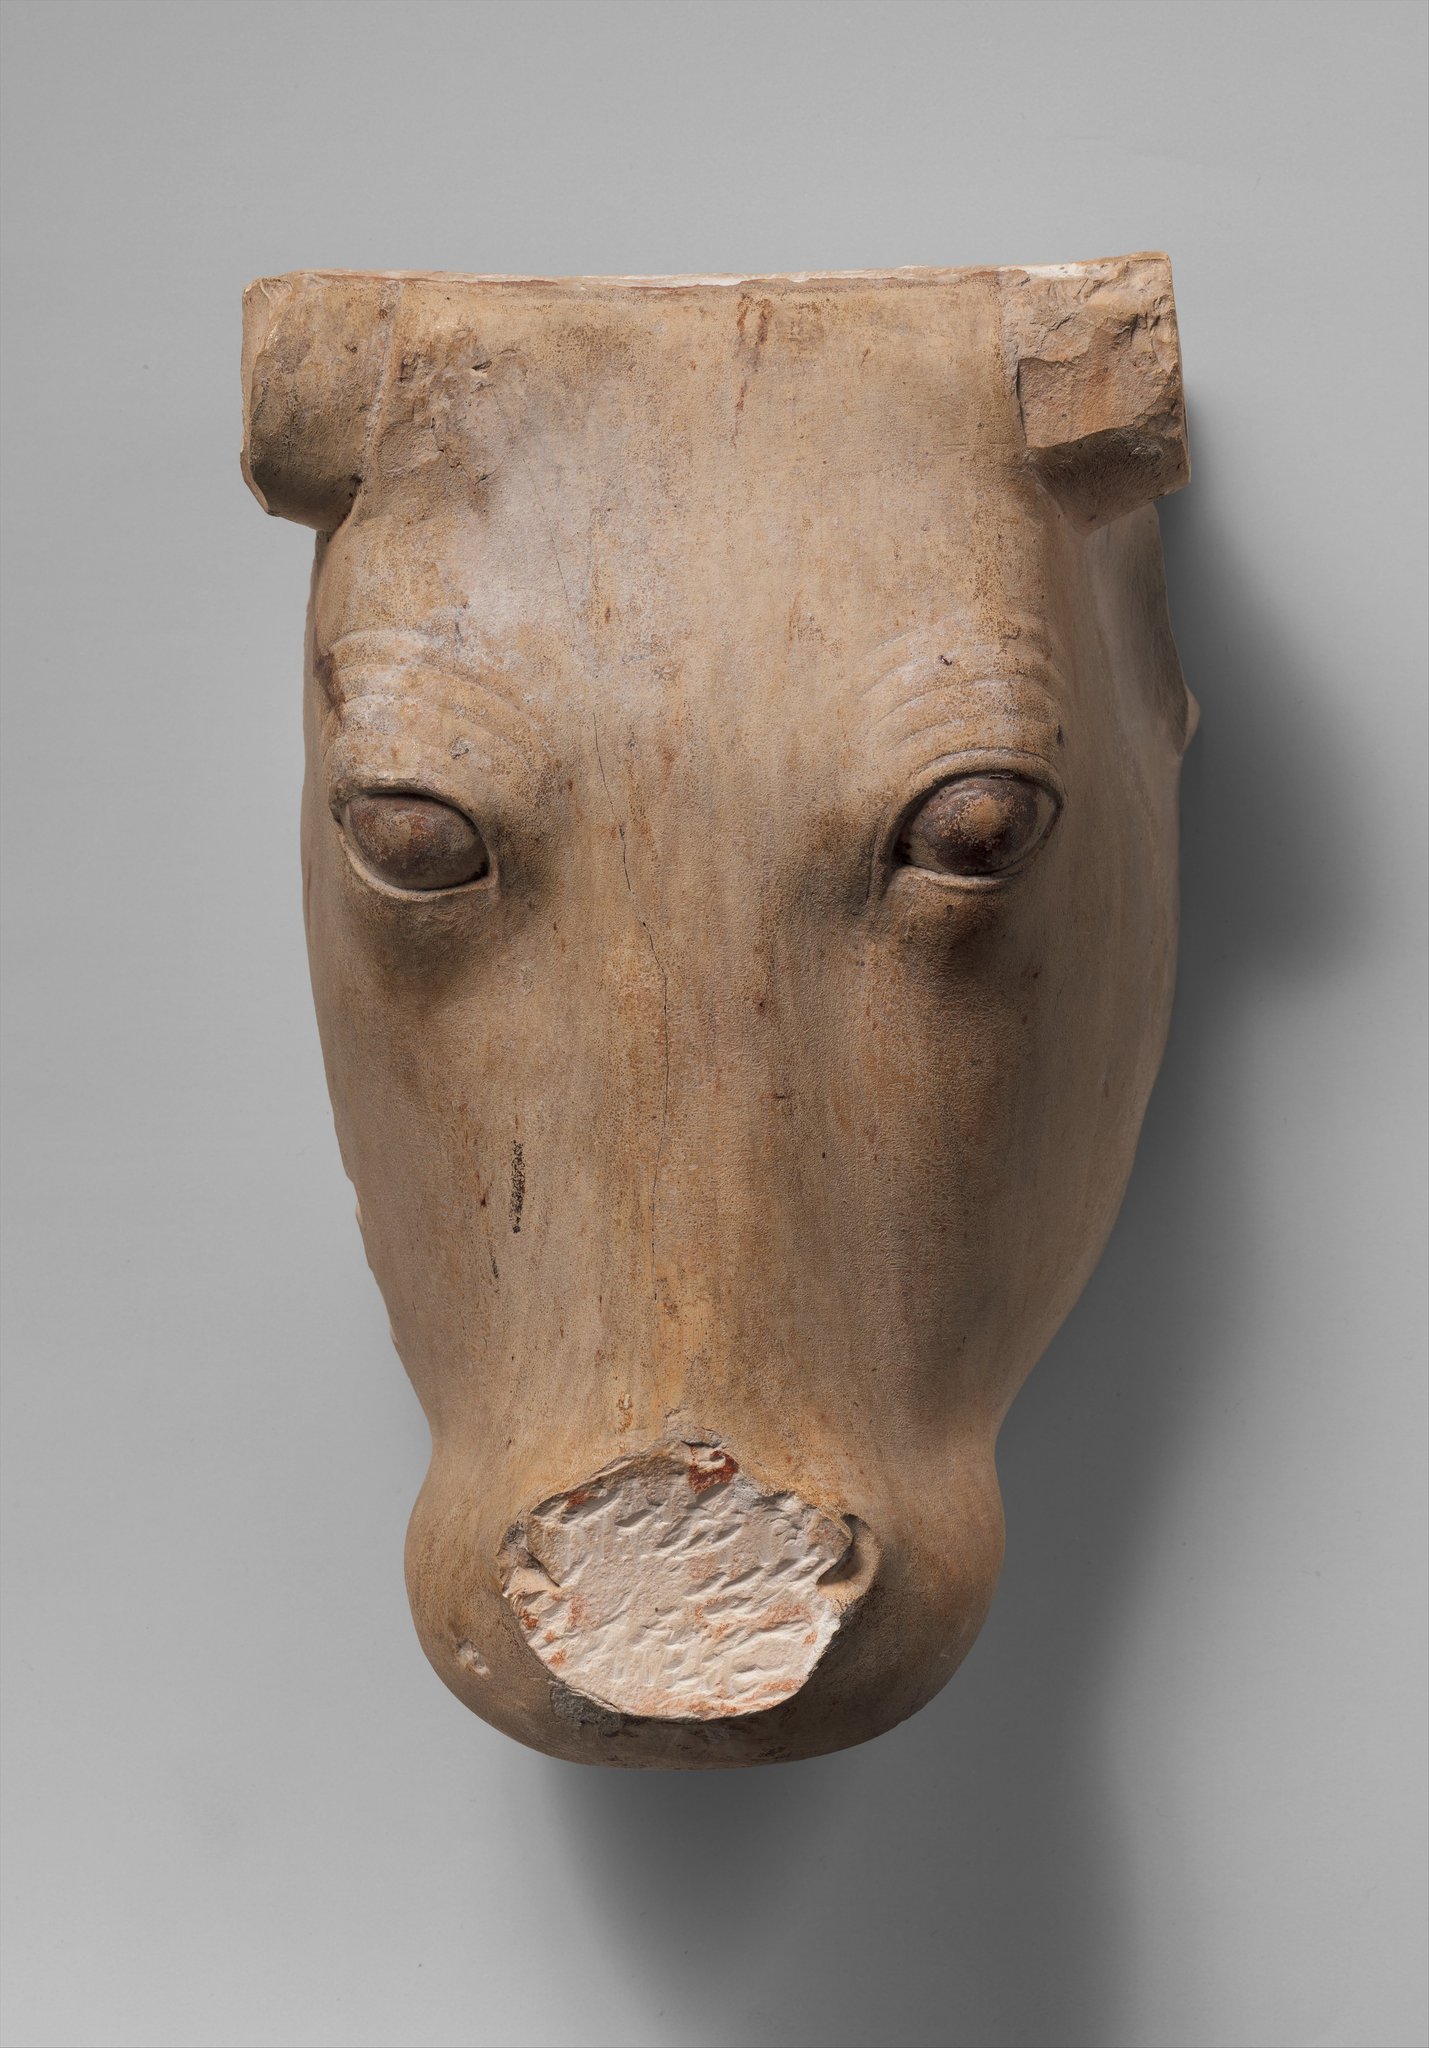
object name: head, cow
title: Cow's Head from a frontal representation of a cow emerging from a wall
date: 664-610 BCE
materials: limestone, paint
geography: egypt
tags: cows